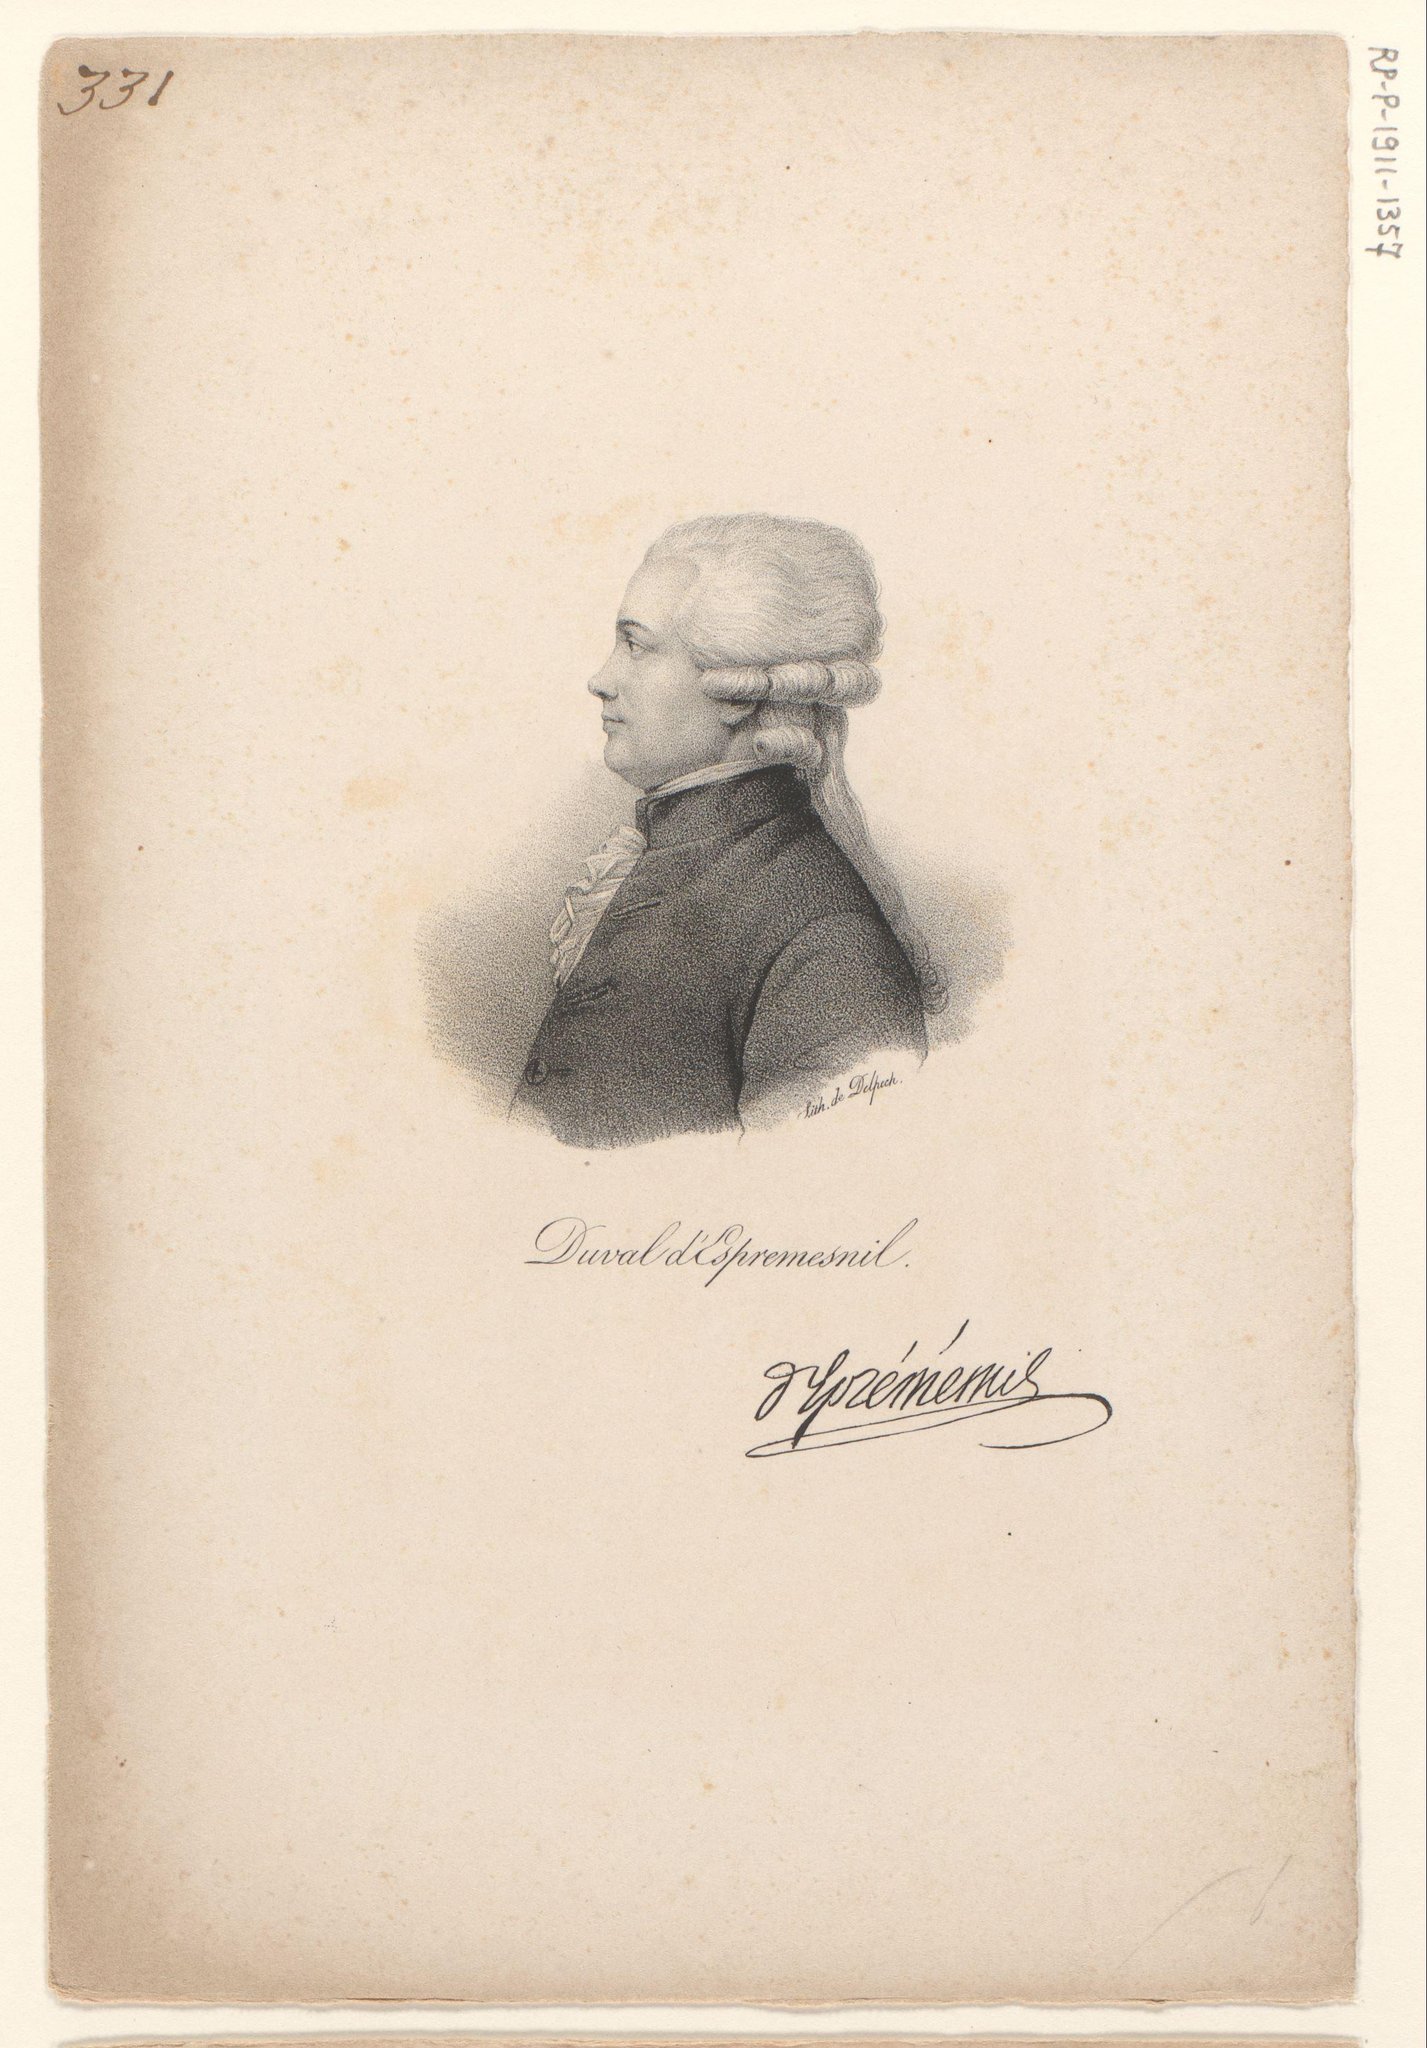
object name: print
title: Portret van Jean-Jacques Duval d'Eprémesnil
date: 1818-1842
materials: paper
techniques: lithograph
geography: paris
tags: paris, politician, historical persons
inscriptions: collector's mark: Lugt 2228a